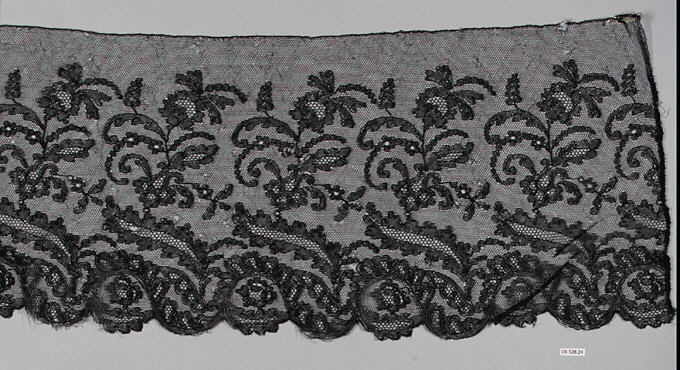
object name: flounce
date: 1801-1900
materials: silk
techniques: lace